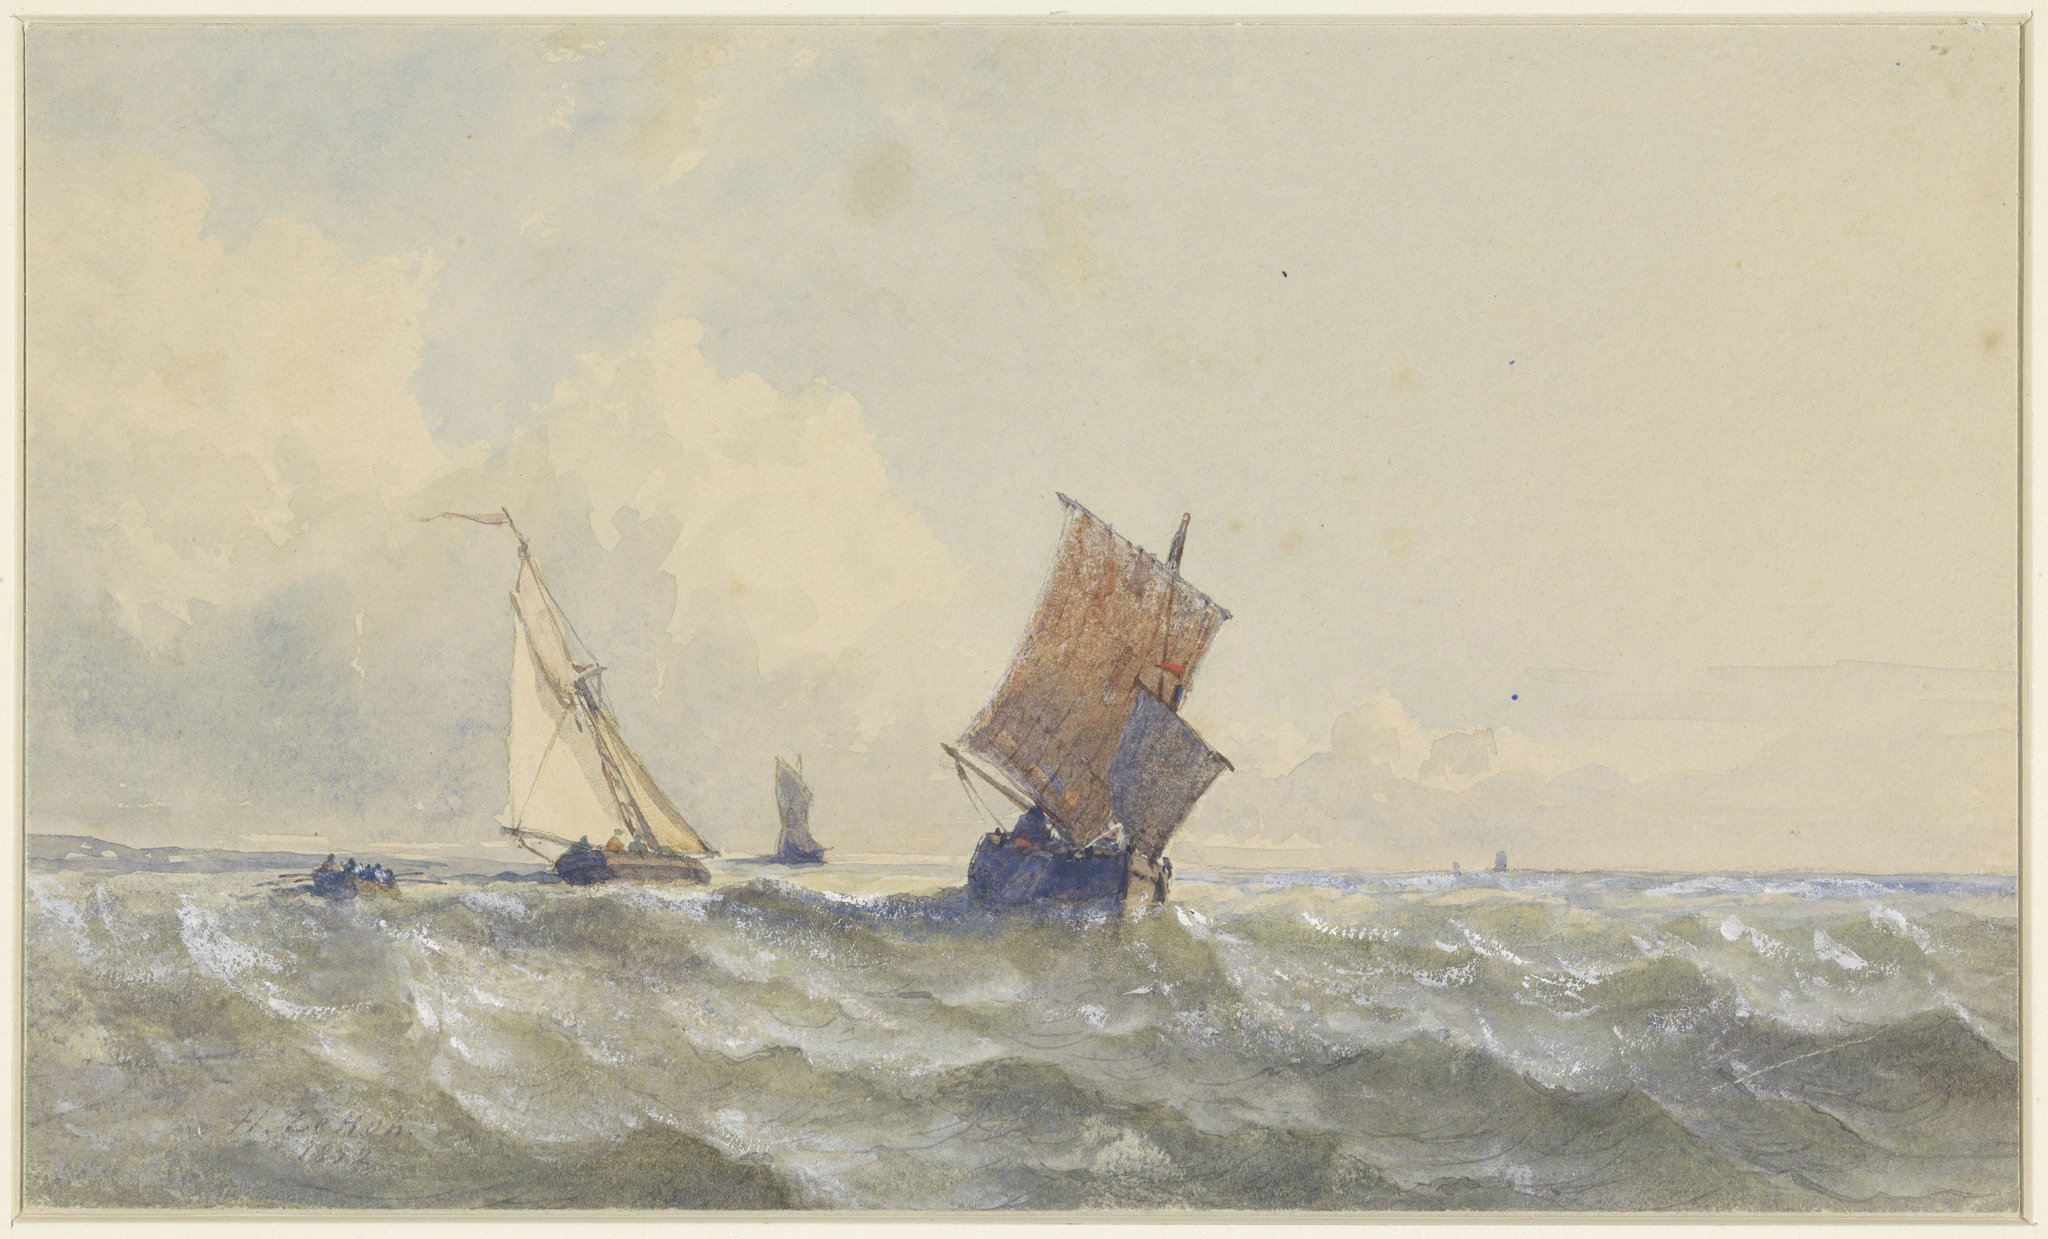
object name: watercolor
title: Gezicht op volle zee, waarop drie zeilschepen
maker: henri le hon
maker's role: draughtsman, print maker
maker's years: 1809-1872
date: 1852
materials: paper, watercolor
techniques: brush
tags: sailing-ship, sailing-boat, sea (seascape)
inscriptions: date: ‘1852’